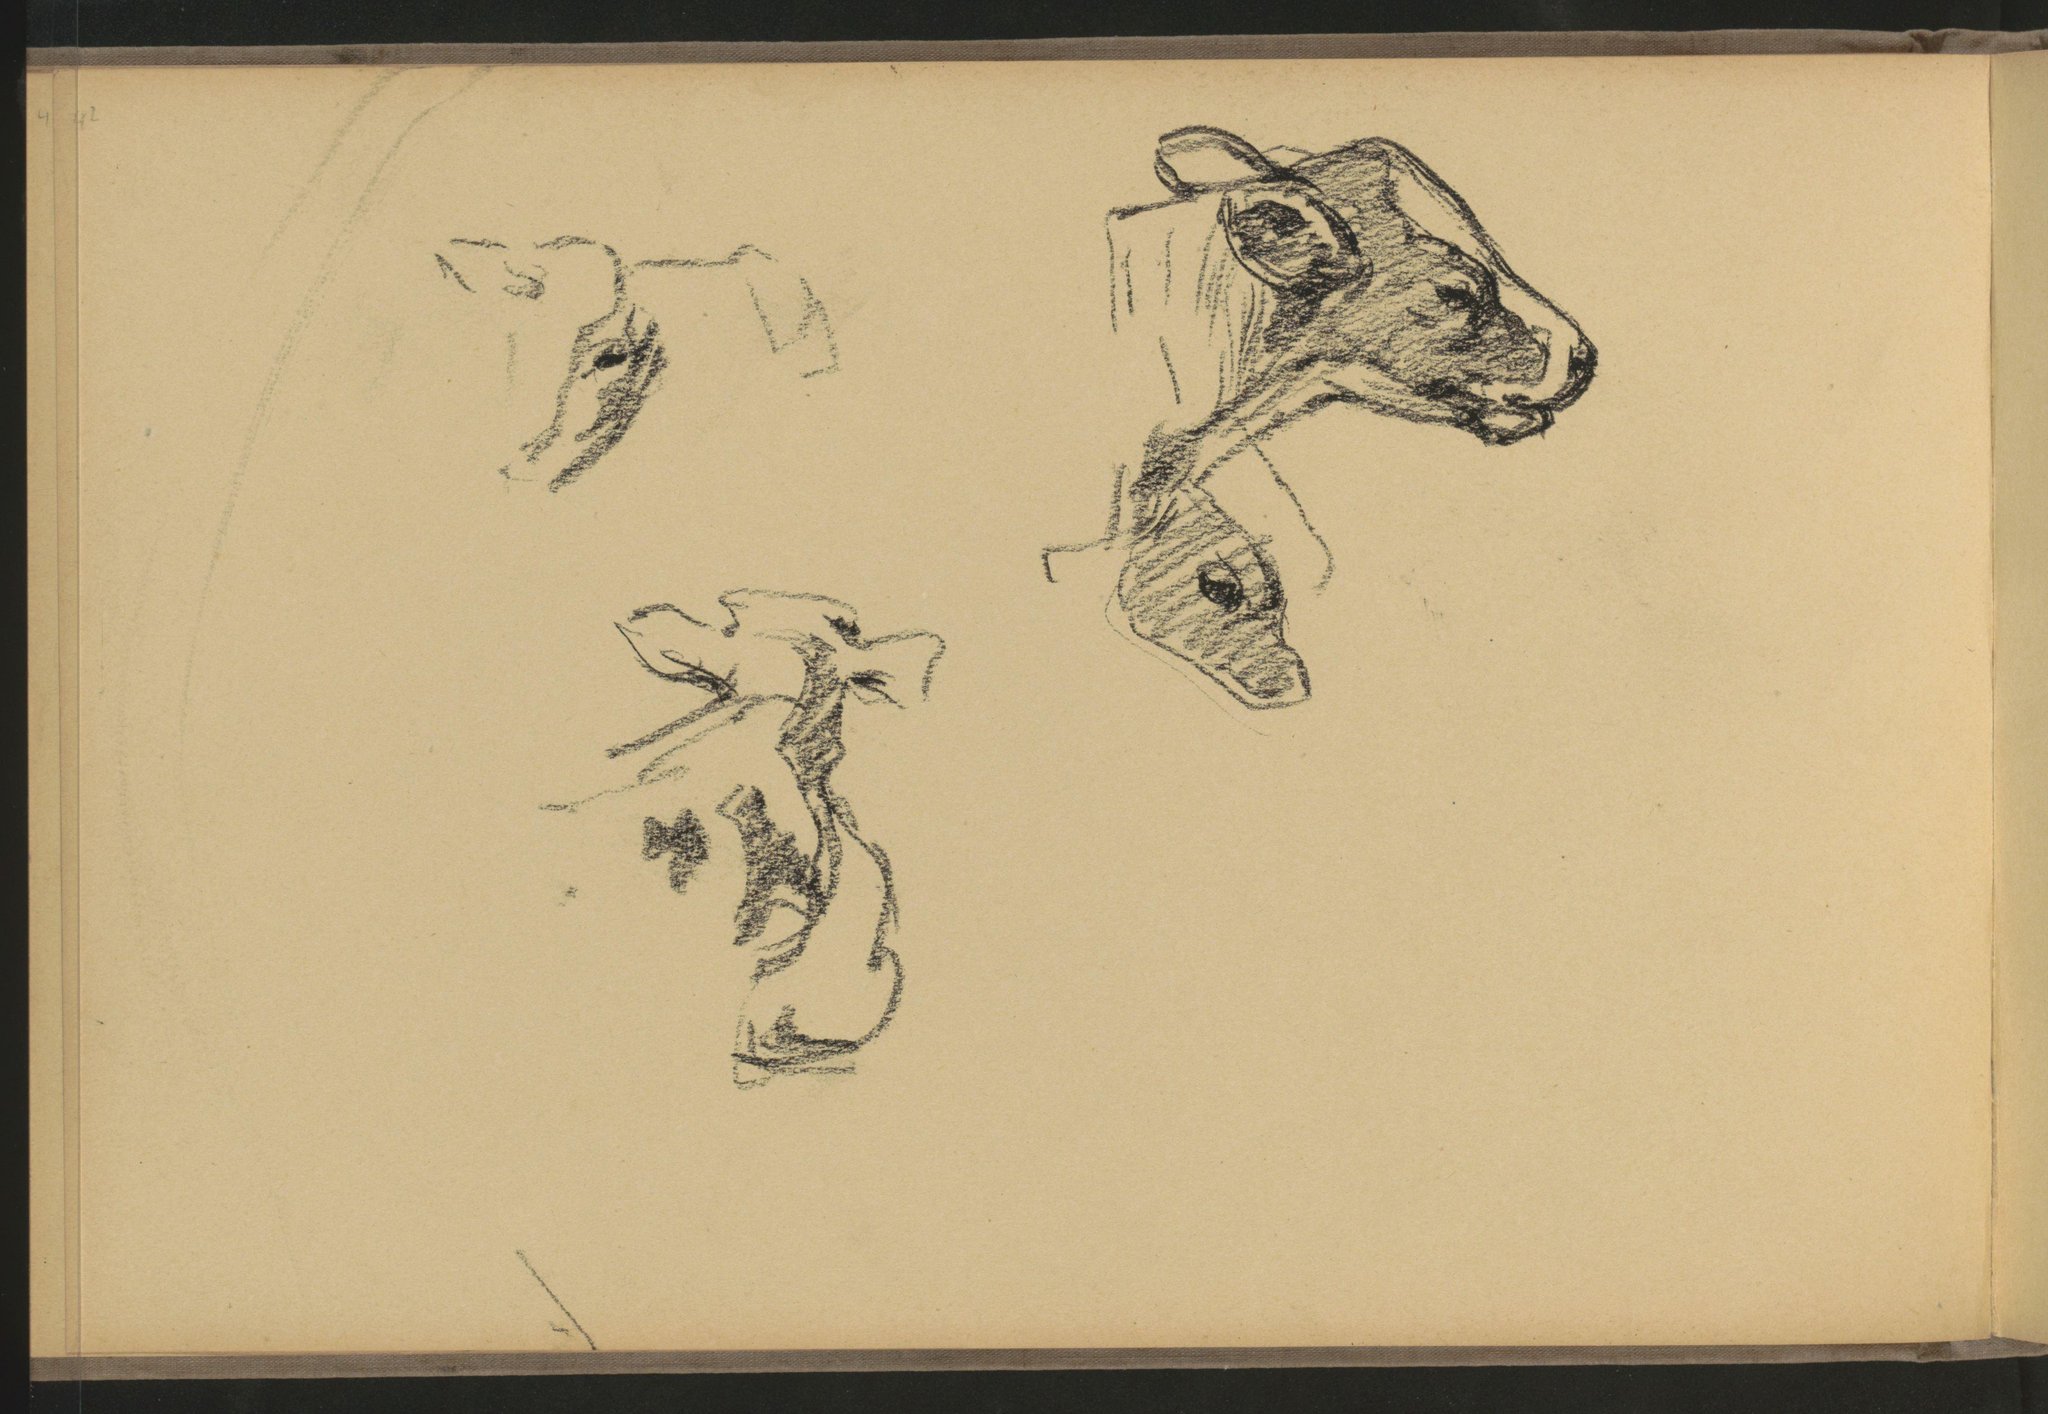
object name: sketchbook leaf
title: Studieblad met koeien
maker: willem witsen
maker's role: draughtsman, painter, print maker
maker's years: 1860-1923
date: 1901-1907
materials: chalk, paper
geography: wijk bij duurstede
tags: cow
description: Pagina 42 uit een schetsboek met 60 bladen.